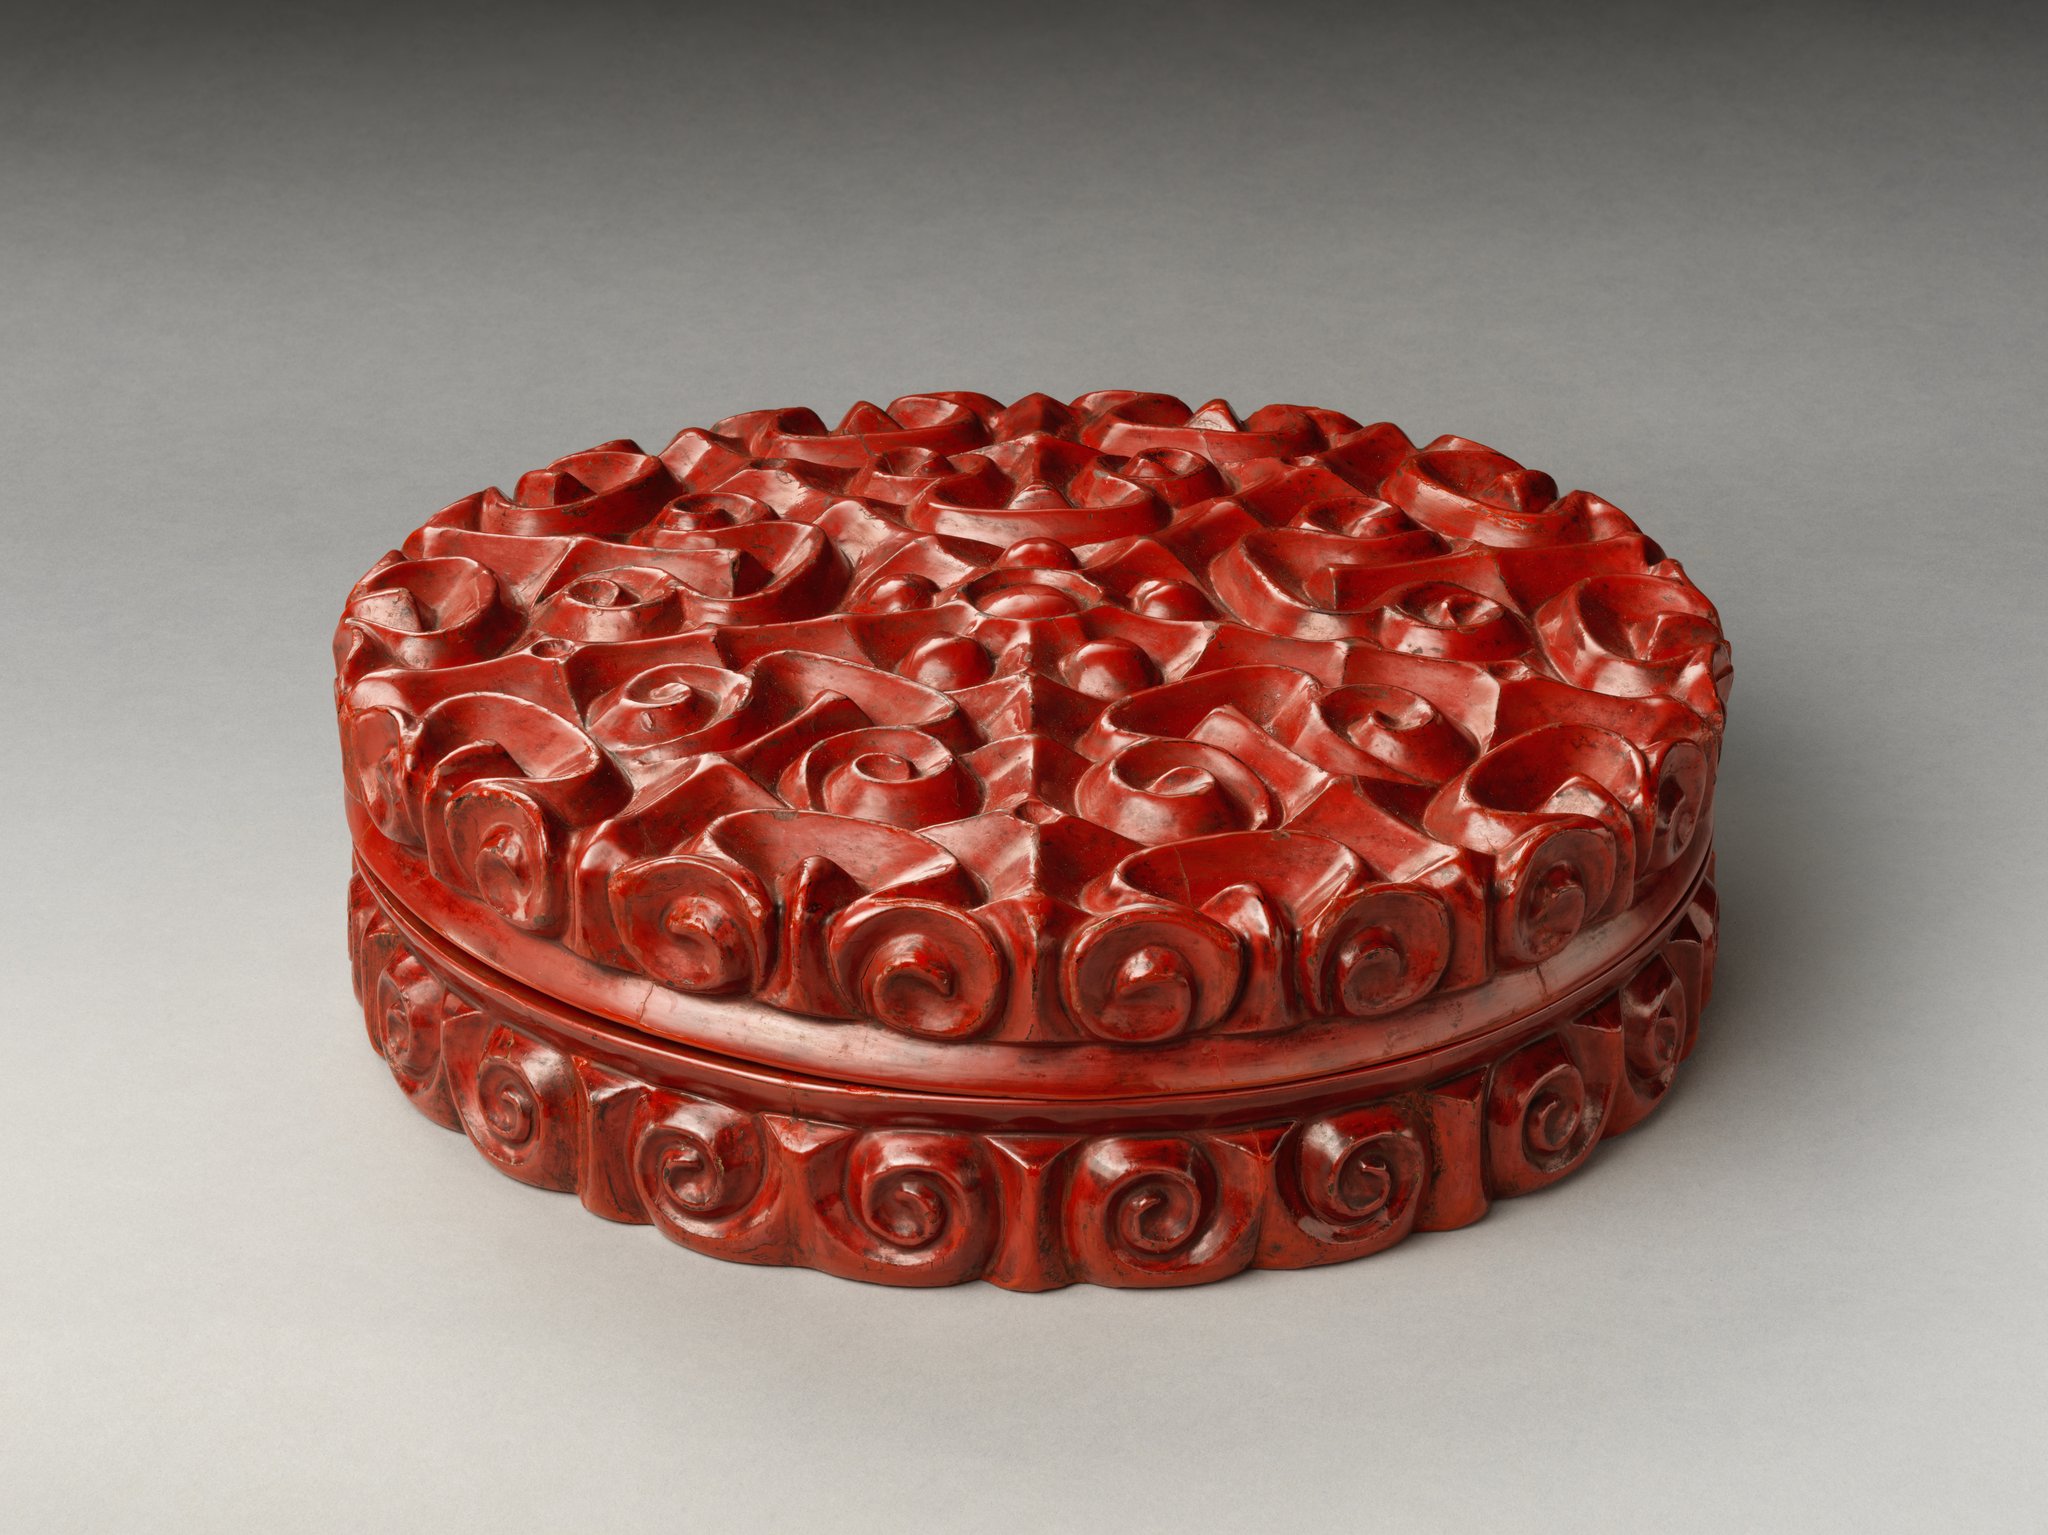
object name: box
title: Incense box with guri pattern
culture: japanese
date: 1501-1600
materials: lacquer, wood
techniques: carving